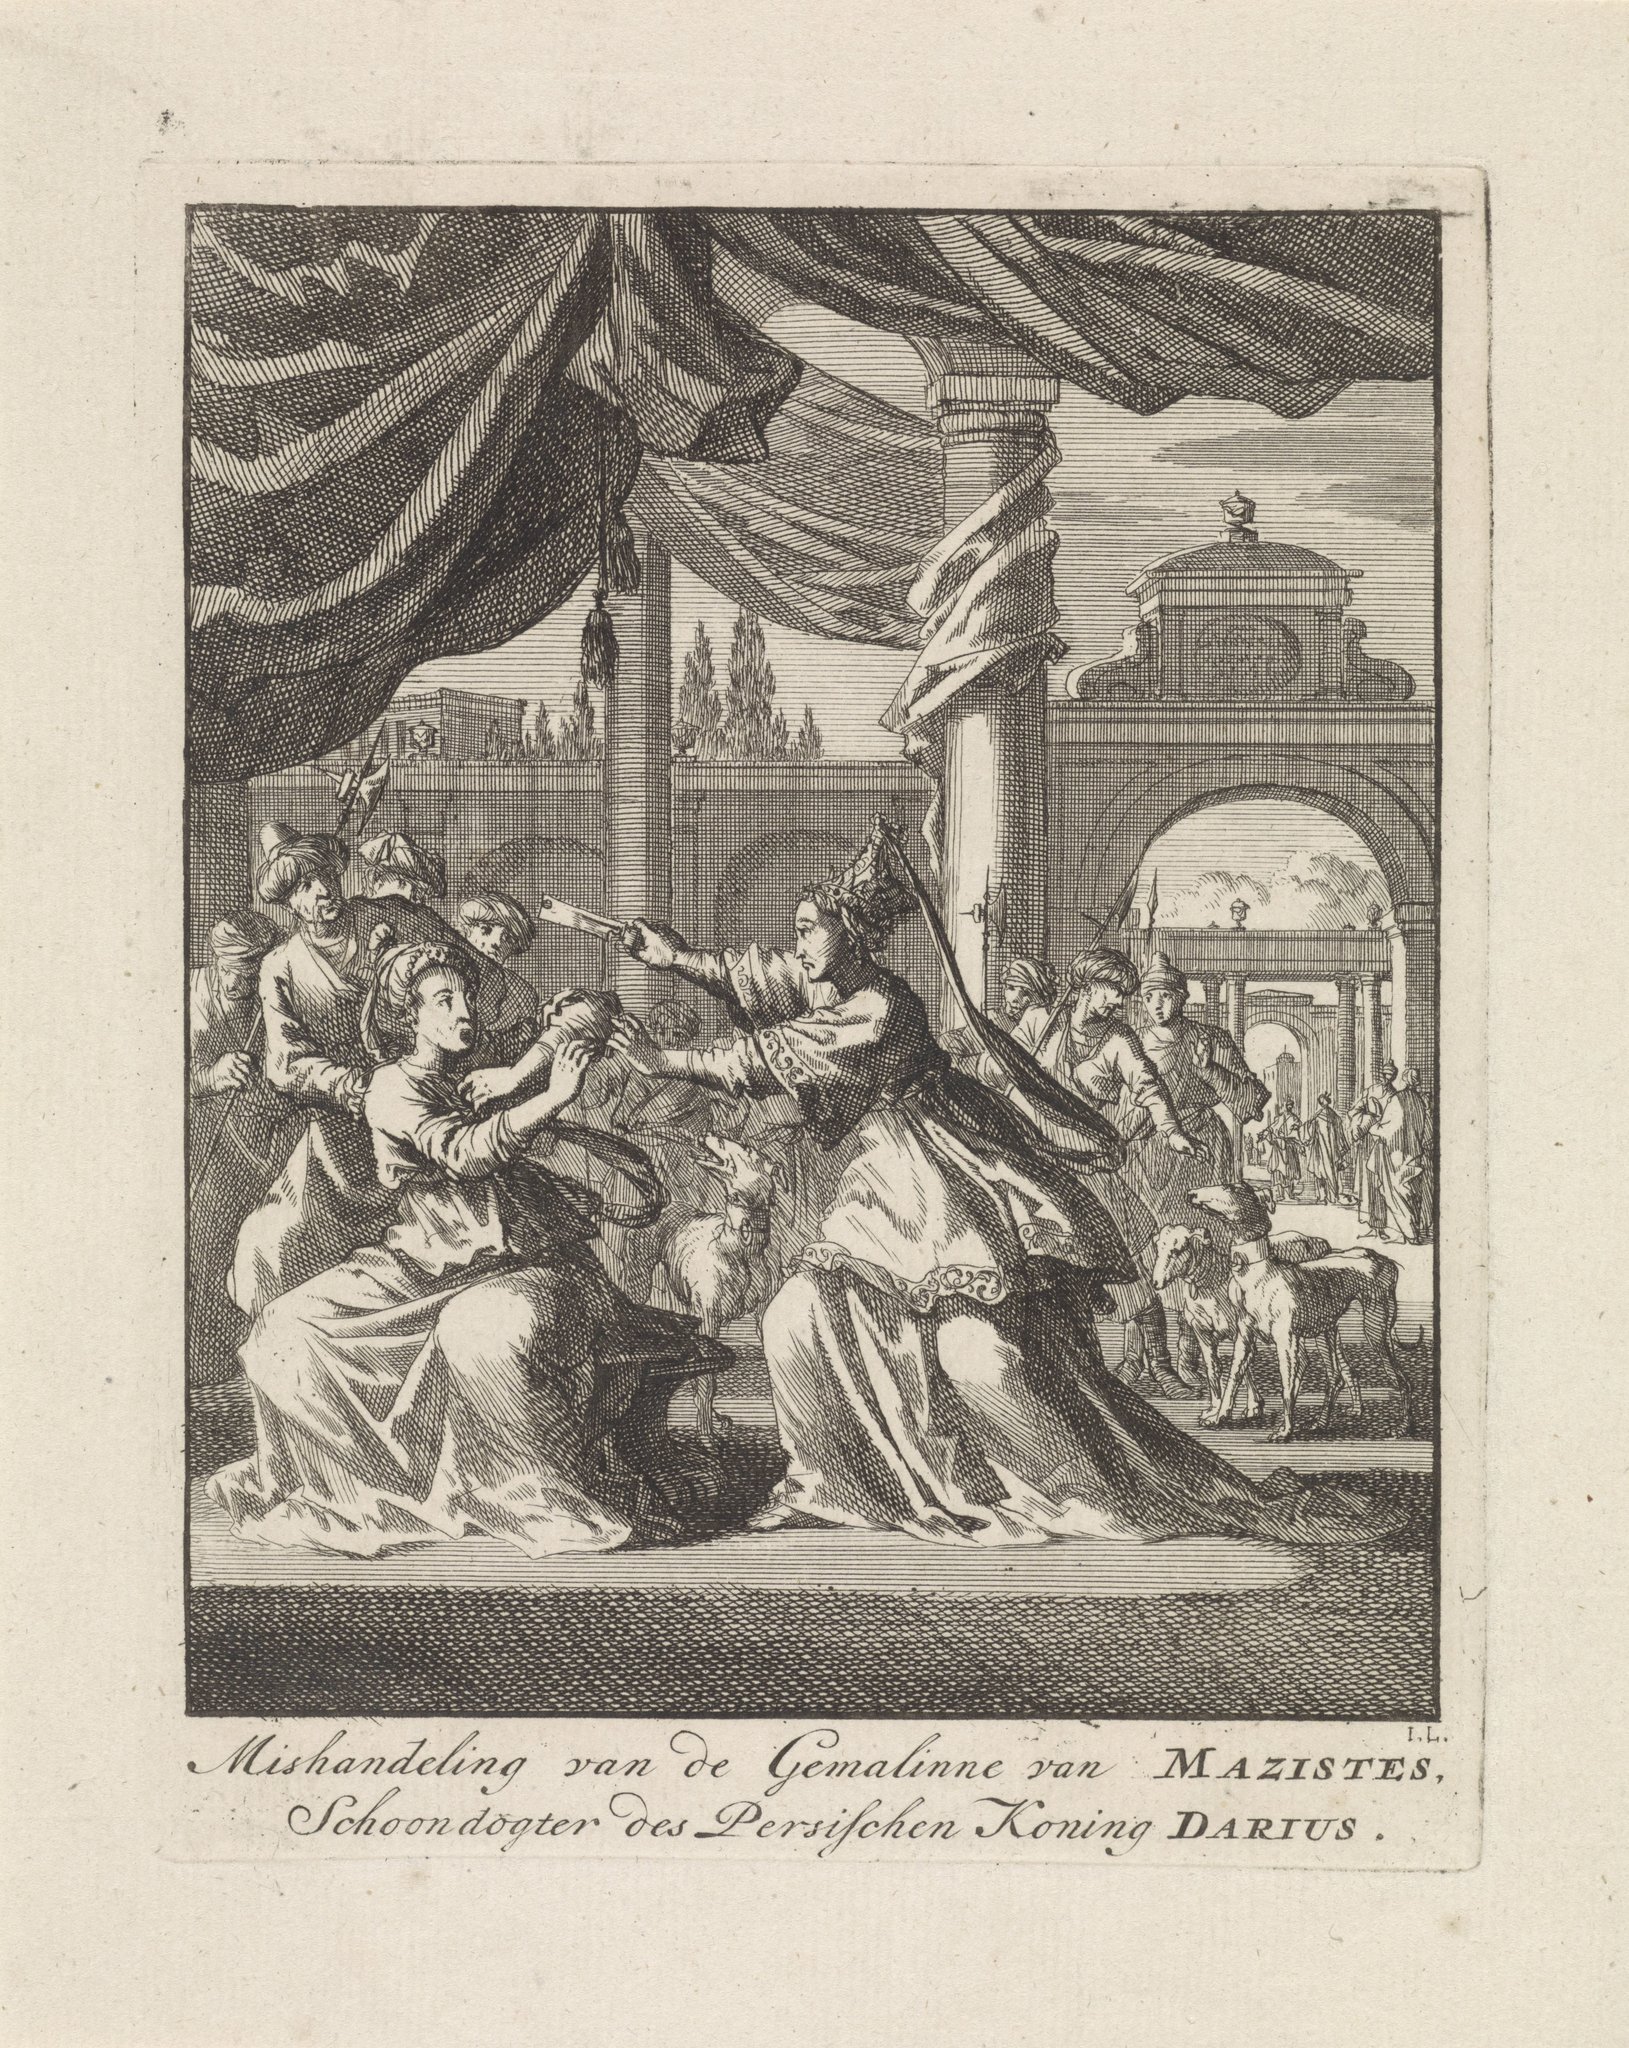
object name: print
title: Mishandeling van de vrouw van Masistes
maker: jan luyken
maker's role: draughtsman, print maker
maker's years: 1649-1712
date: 1699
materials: paper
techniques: etching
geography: amsterdam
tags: male persons from classical history (masistes), rivalry of women for the love of a man; fight for the hose; 'andouille', fighting, male persons from classical history (xerxes)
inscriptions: collector's mark: Lugt 2228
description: Ook als boekillustratie voor: Zanten, Laurens van. Treur-tooneel der doorluchtige vrouwen, of Op en ondergang der vorstinnen. Amsterdam: Jan ten Hoorn, 1699.